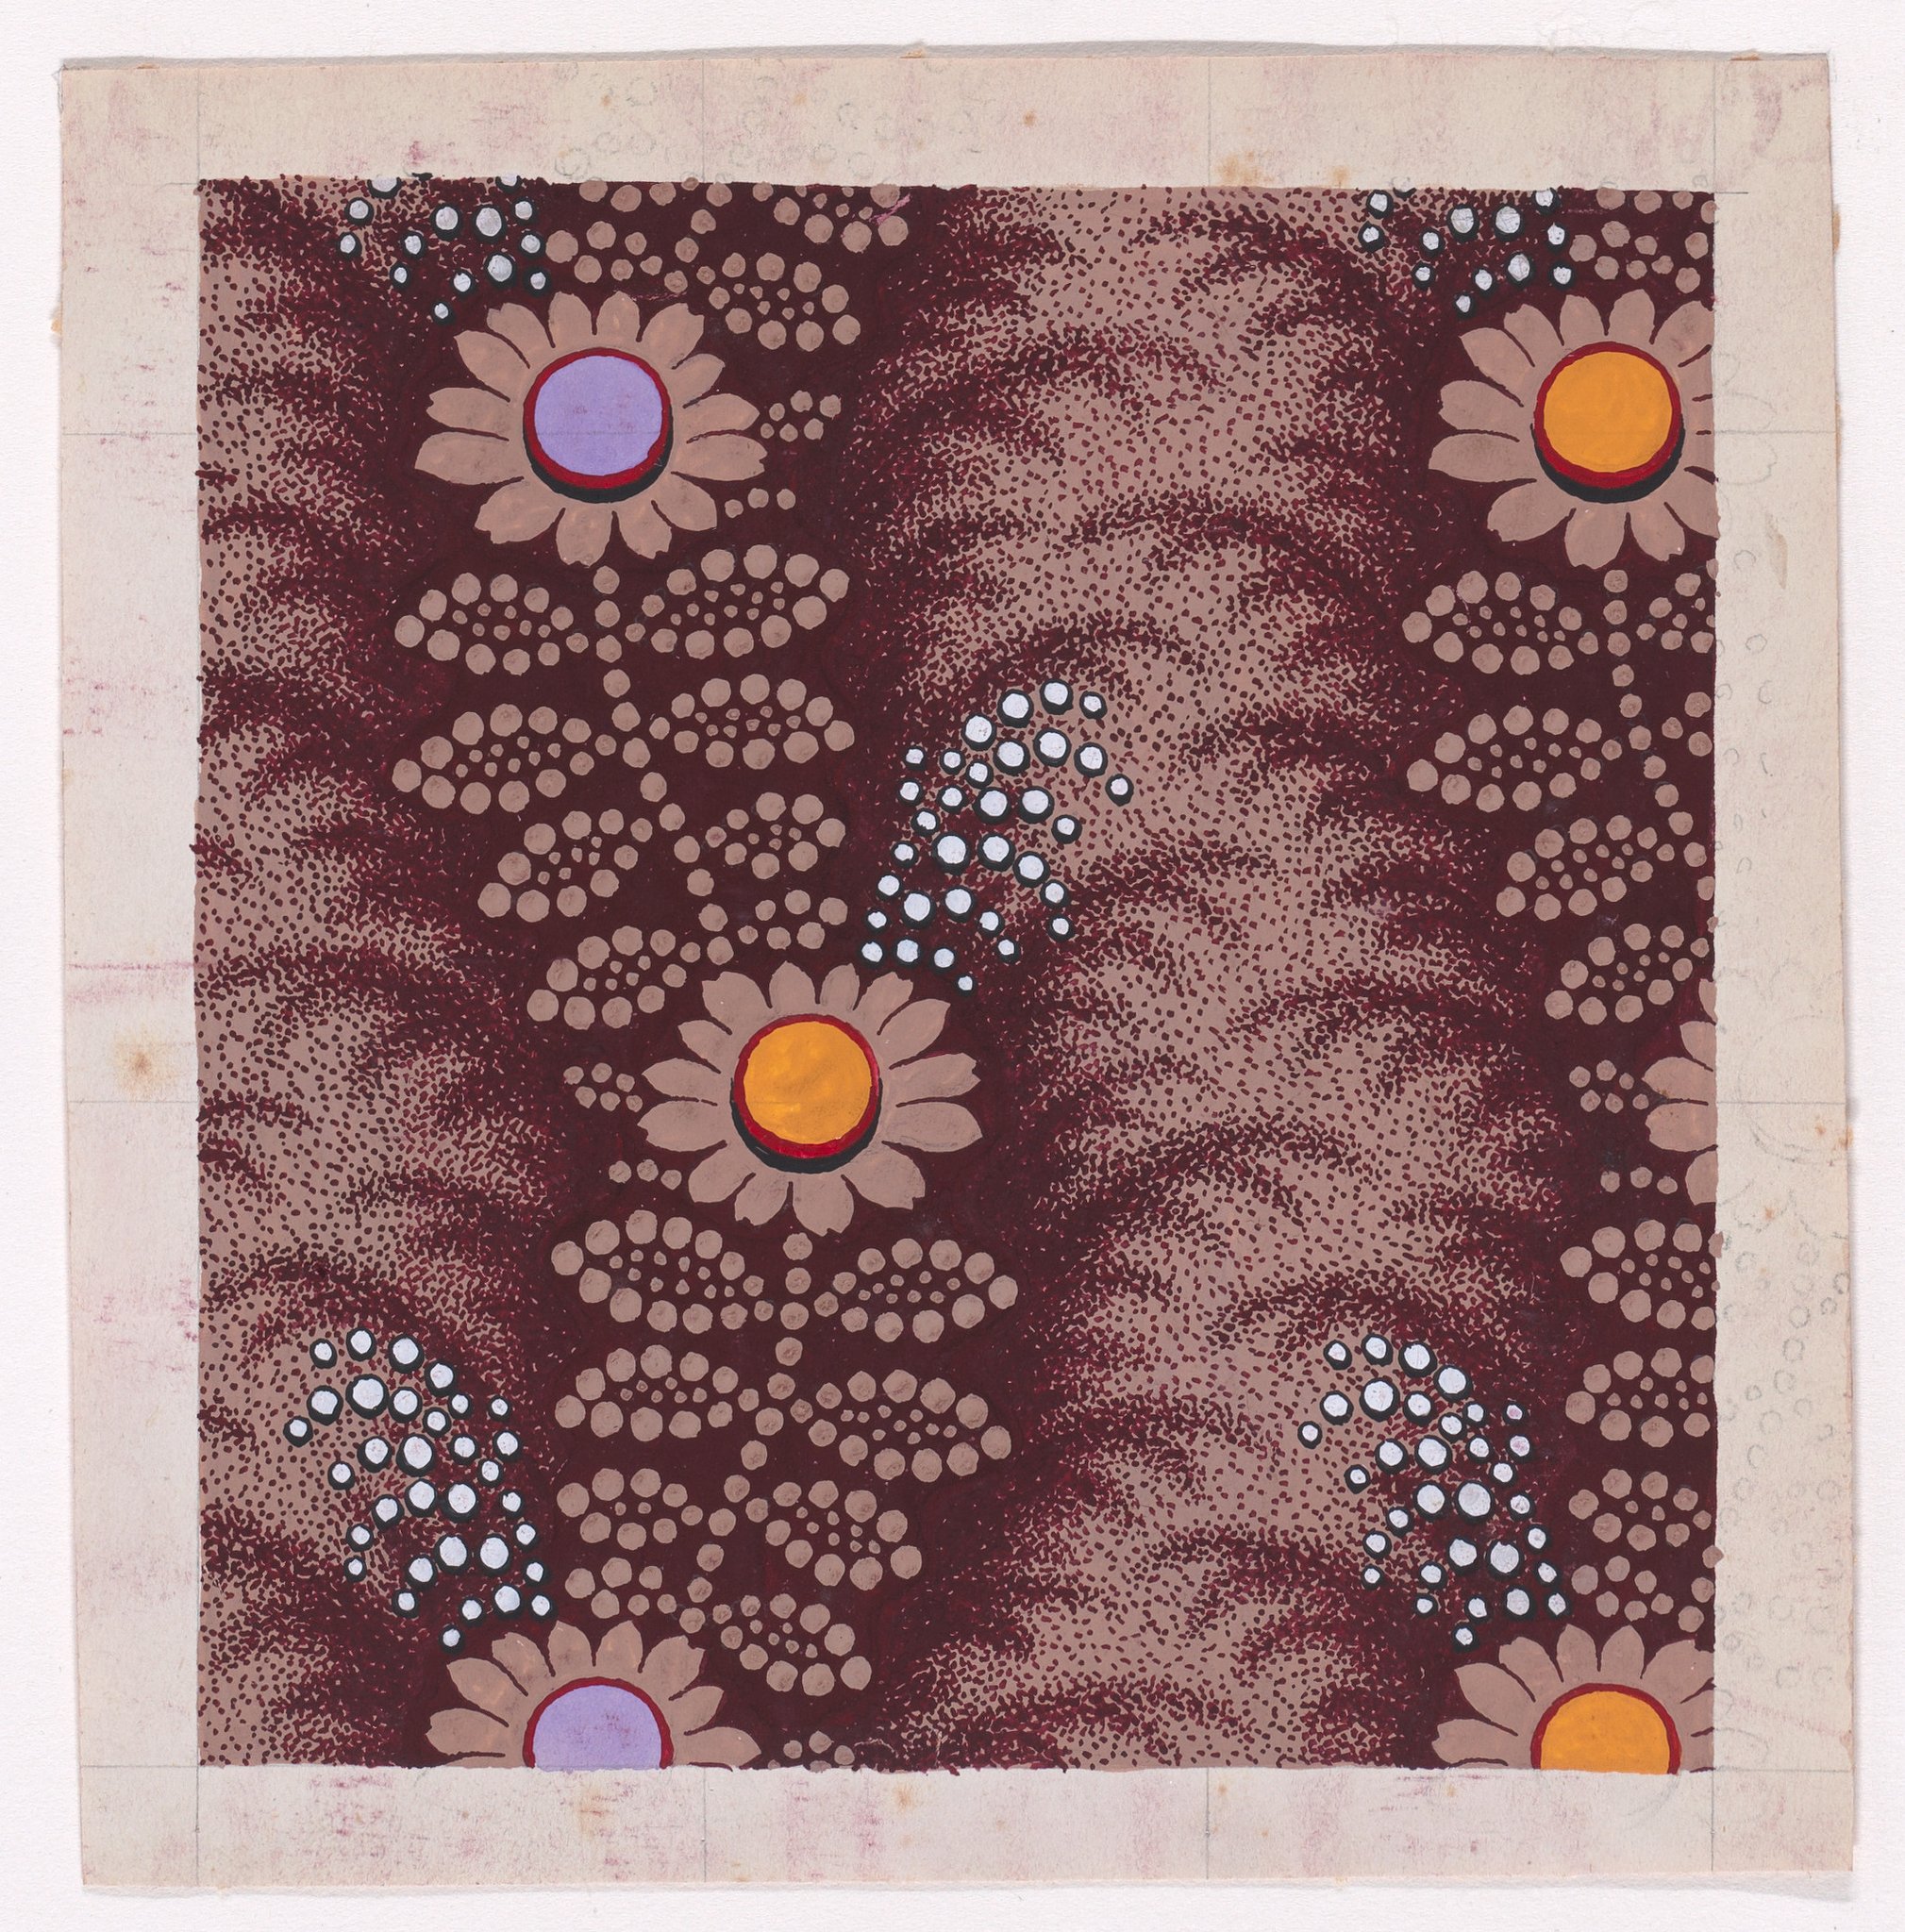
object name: drawing ornament architecture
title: Textile Design with Vertical Undulating Garlands of Stylized Daisies with Pearls and Leaves over a Stippled Background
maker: anonymous, alsatian, 19th century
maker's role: artist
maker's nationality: alsatian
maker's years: 1800-1900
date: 1840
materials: gouache